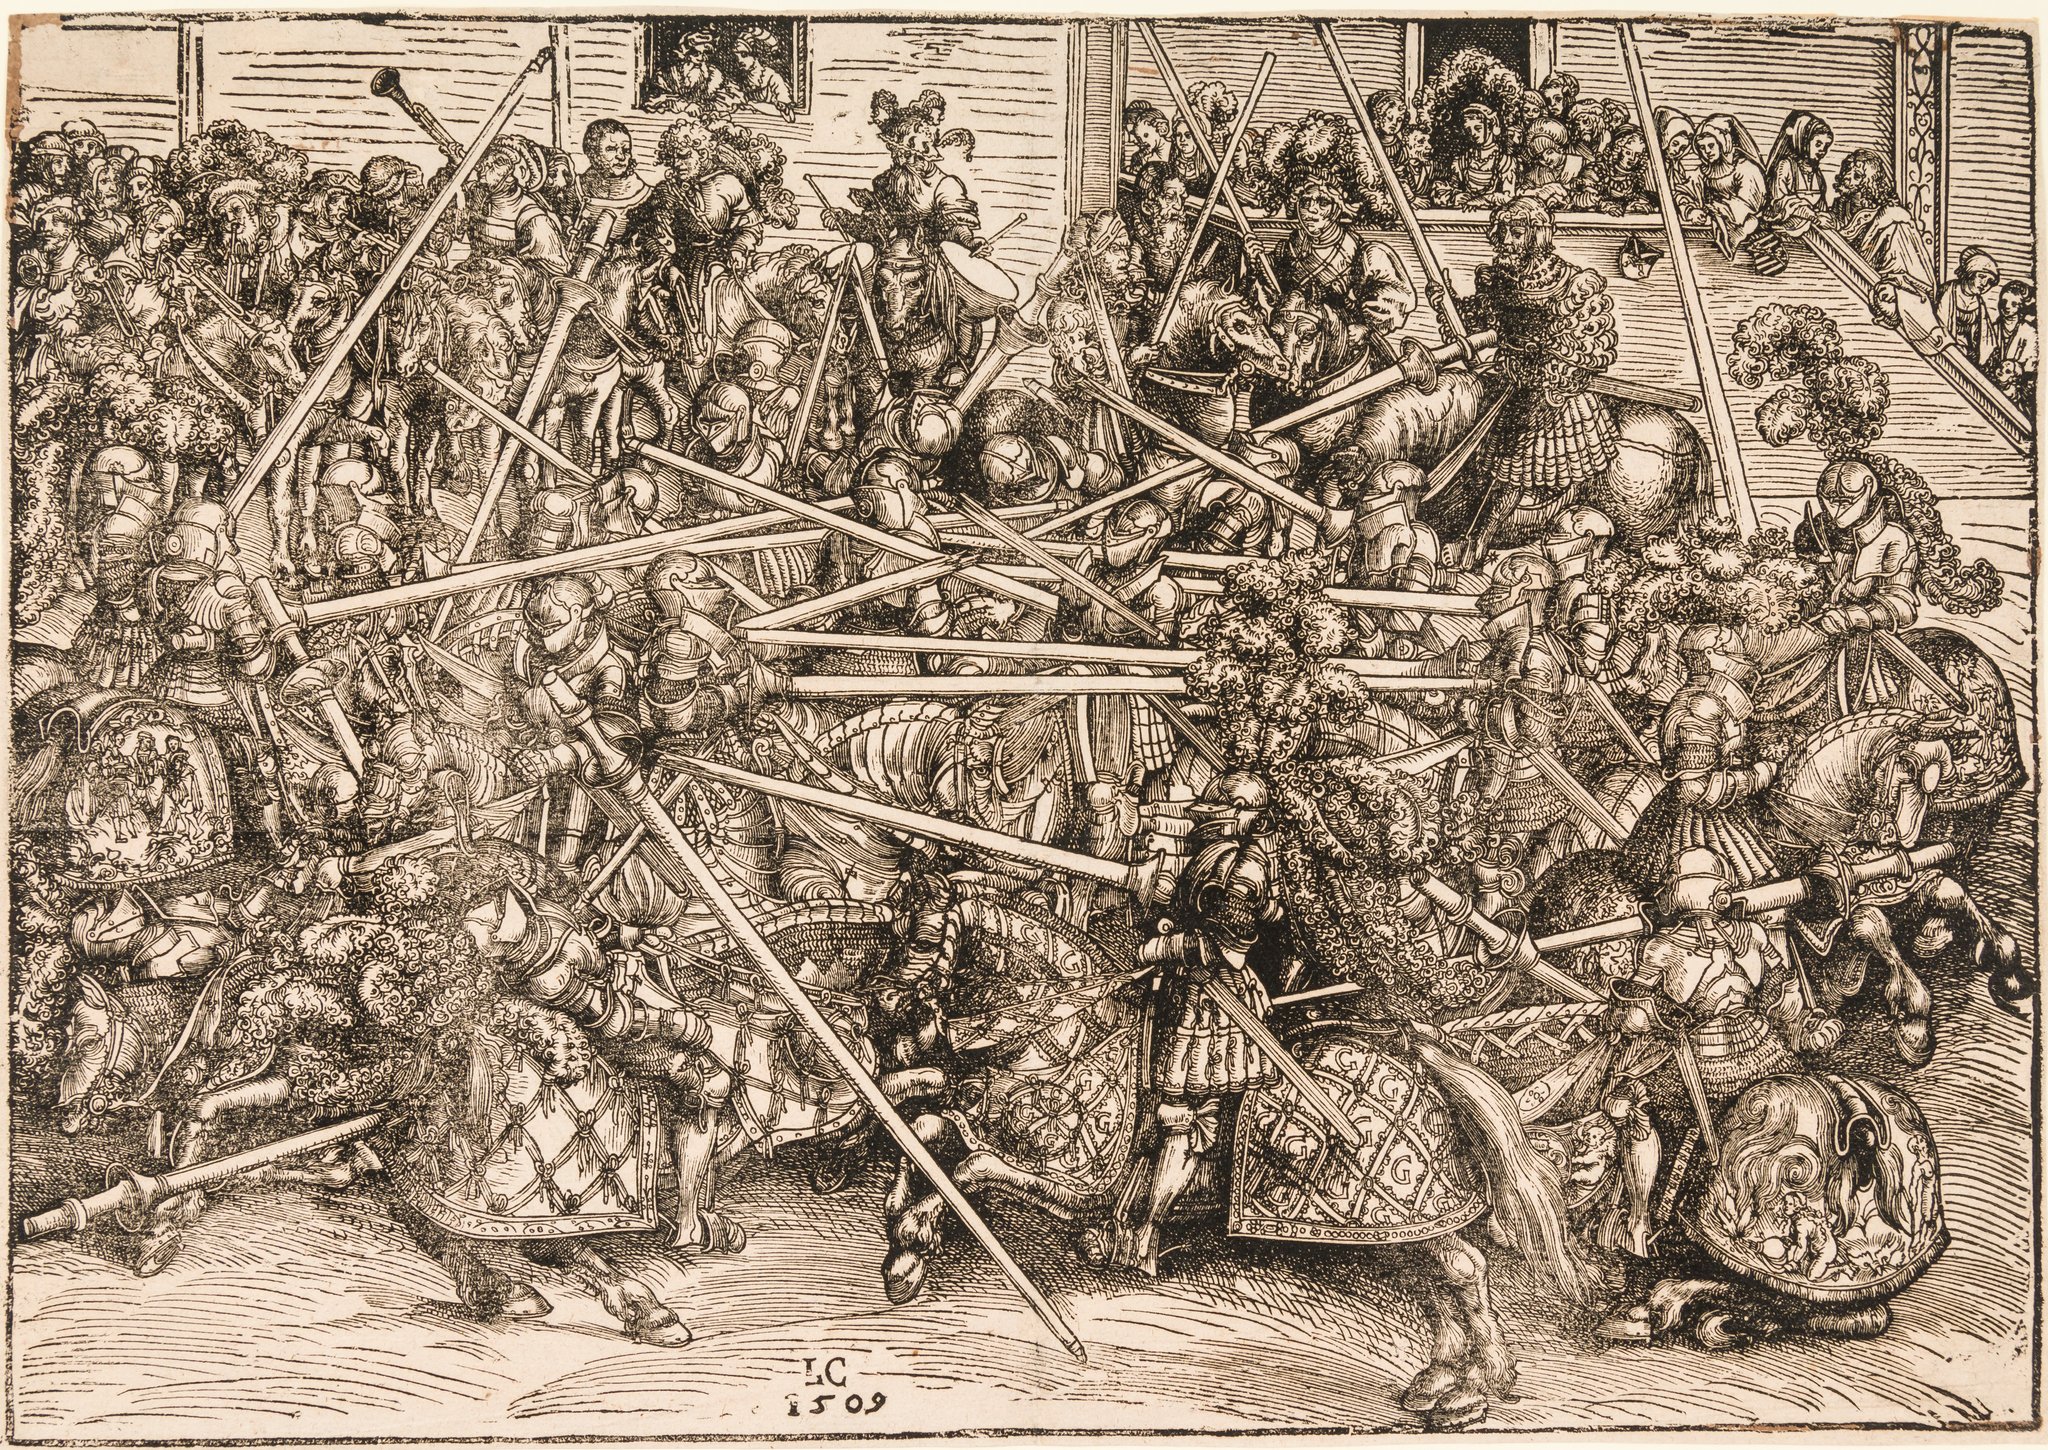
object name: woodcut, print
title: The Tournament with Lances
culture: german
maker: lucas cranach the elder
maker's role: artist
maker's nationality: german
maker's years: 1472-1553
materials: ink, paper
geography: germany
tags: men,women,horses